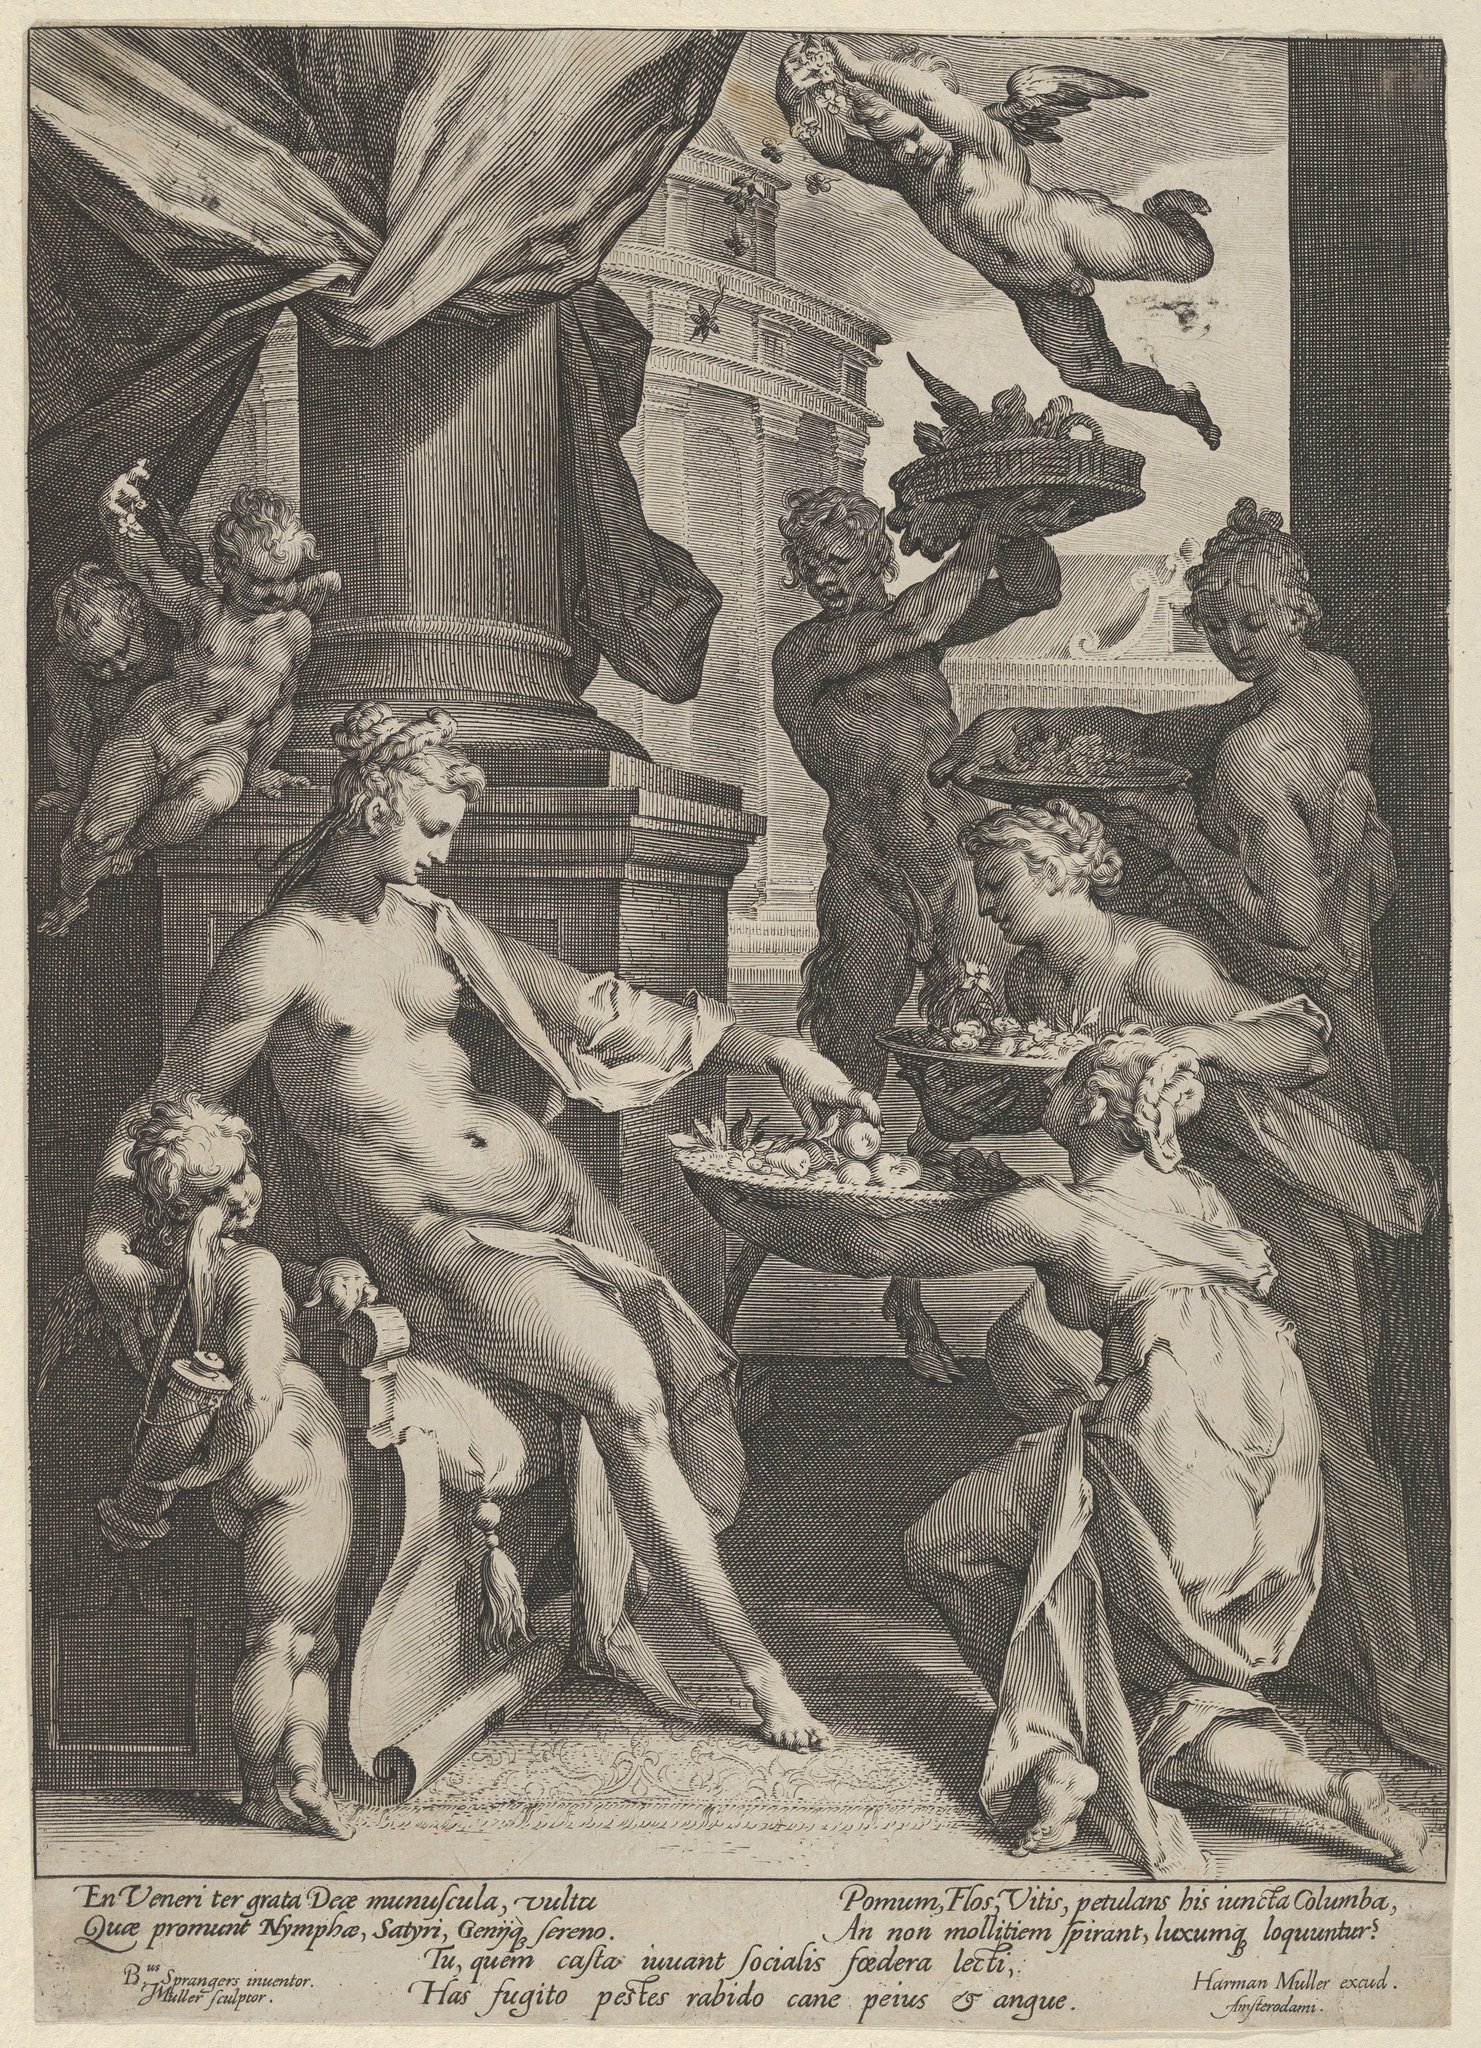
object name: print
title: Venus Honored by the Nymphs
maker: jan muller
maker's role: artist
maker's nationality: netherlandish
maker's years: 1571-1628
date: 1591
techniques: engraving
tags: nymphs,venus